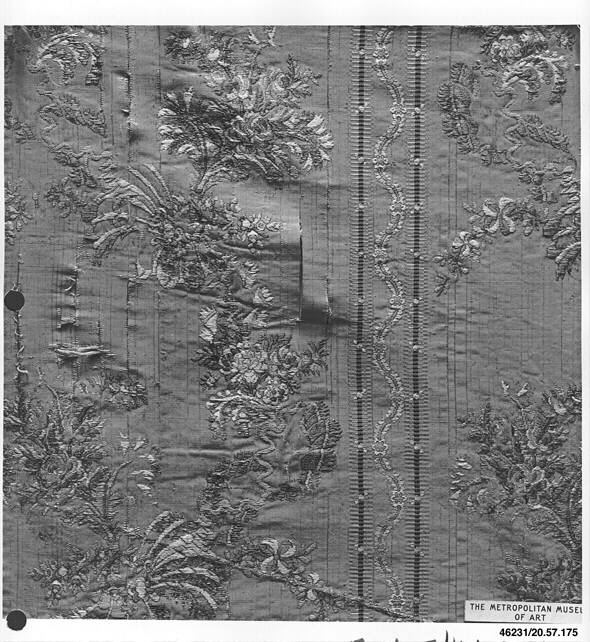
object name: piece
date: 1750-1775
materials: metal thread, silk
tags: flowers,leaves